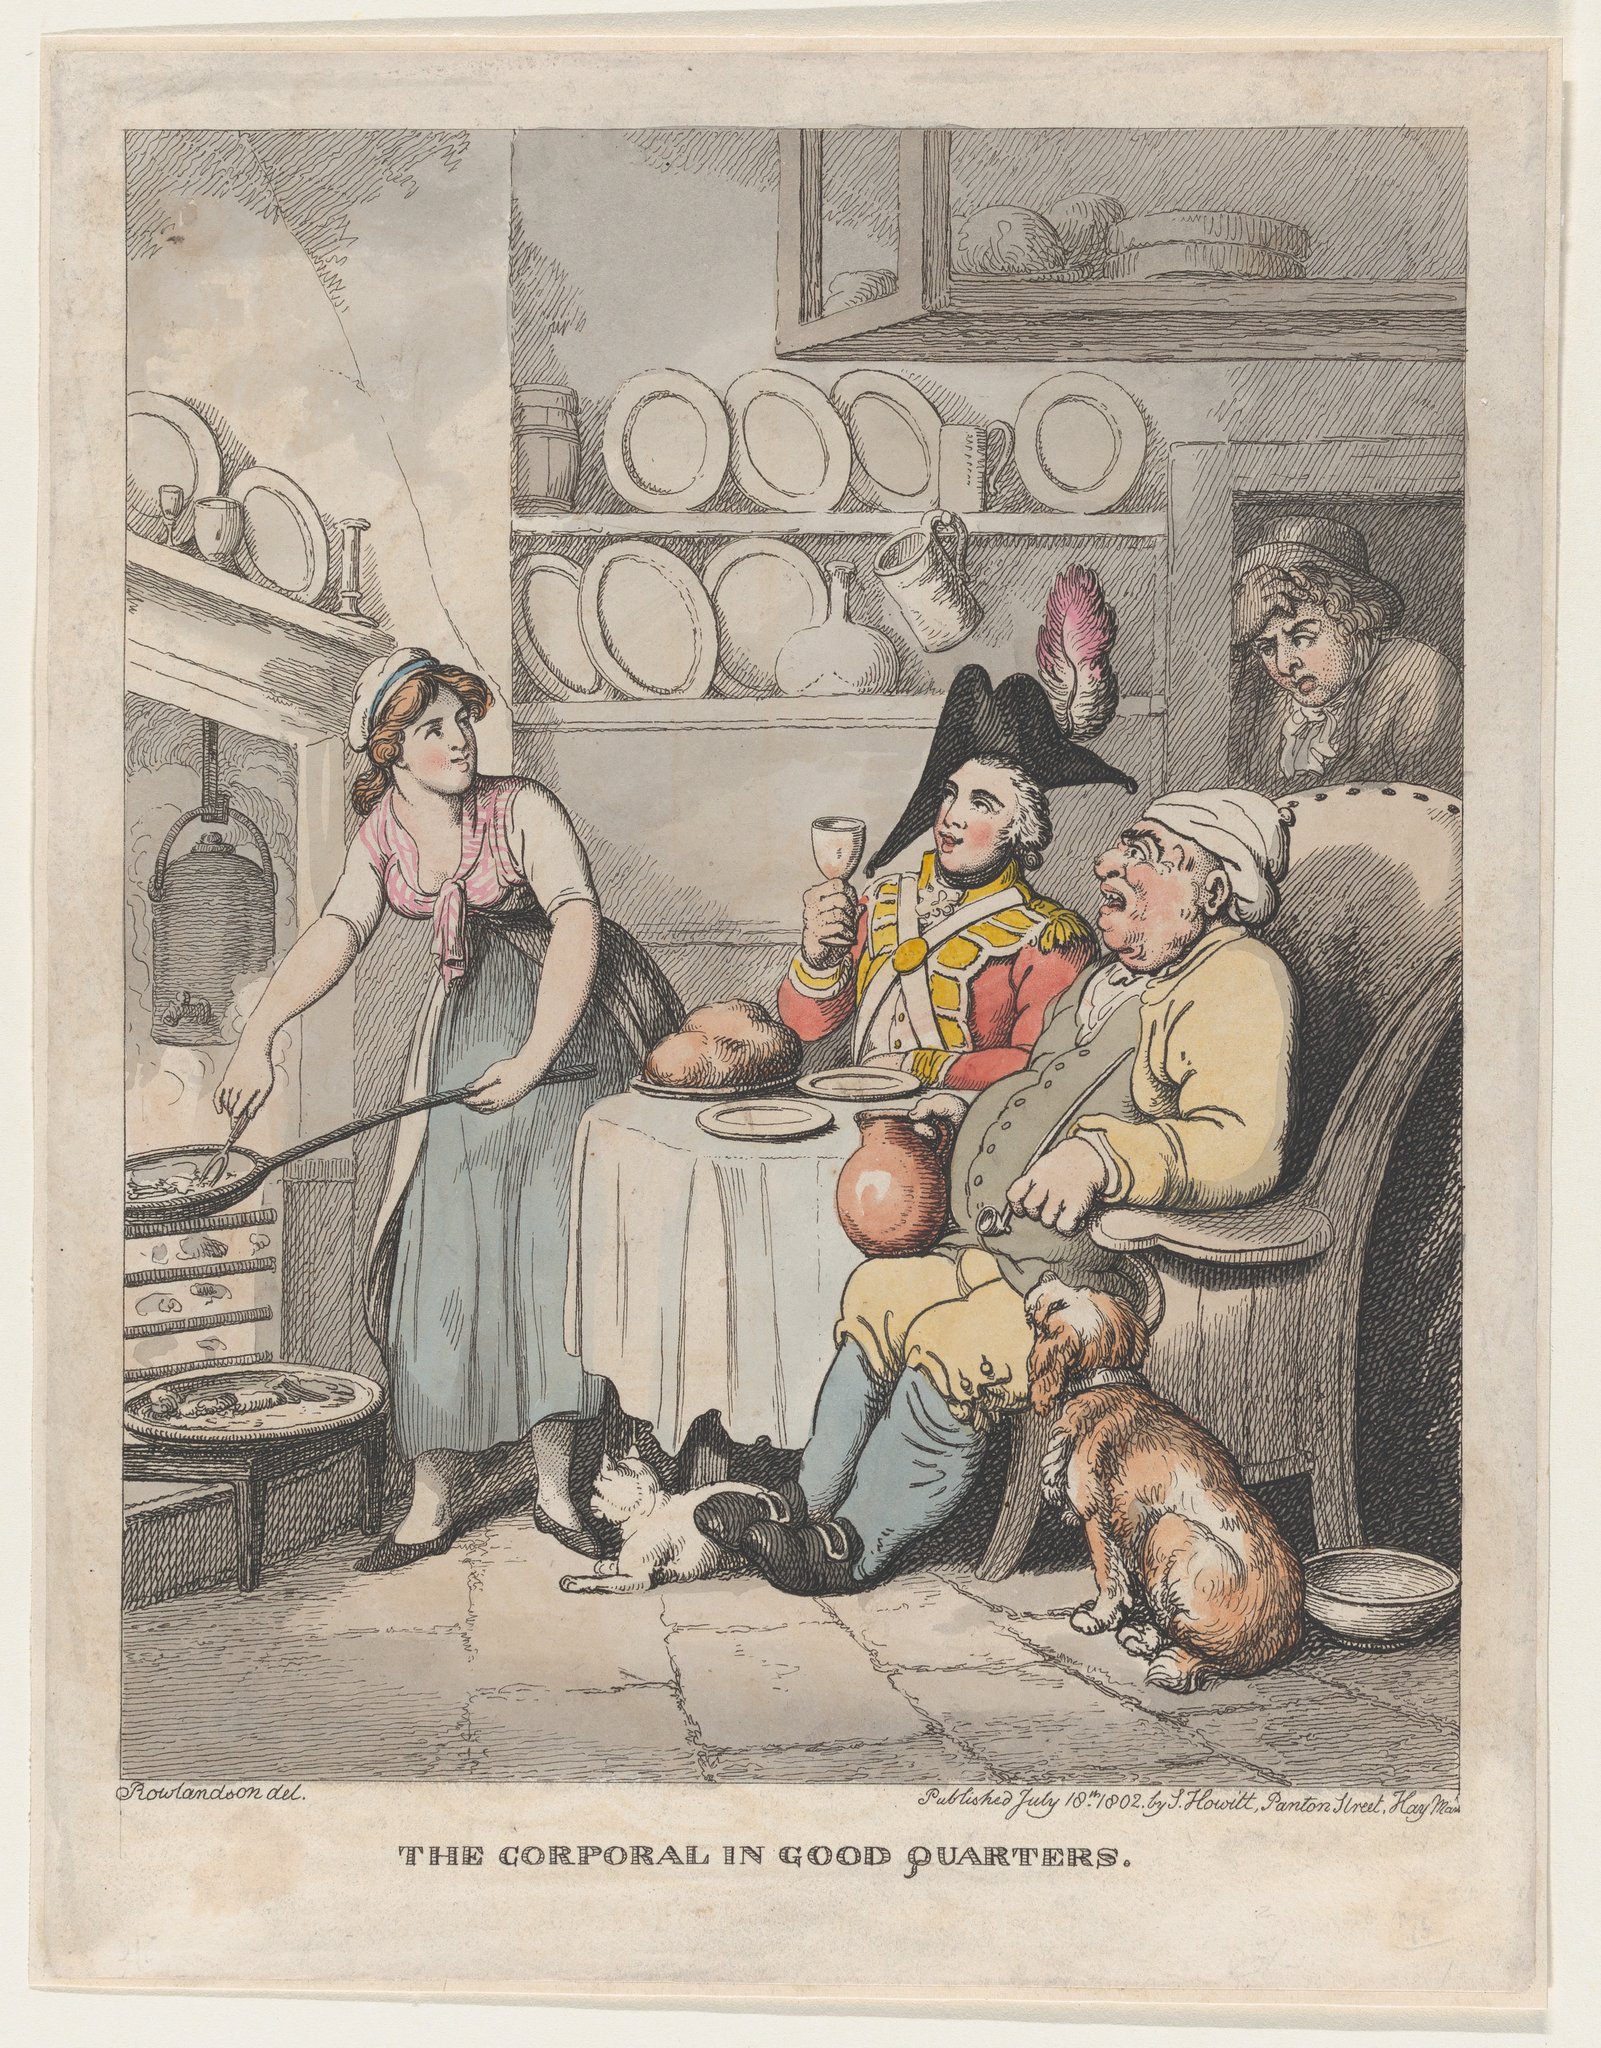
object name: print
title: The Corporal in Good Quarters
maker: thomas rowlandson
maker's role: artist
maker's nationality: british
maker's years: 1757-1827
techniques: etching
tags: men,women,cats,dogs,drinking